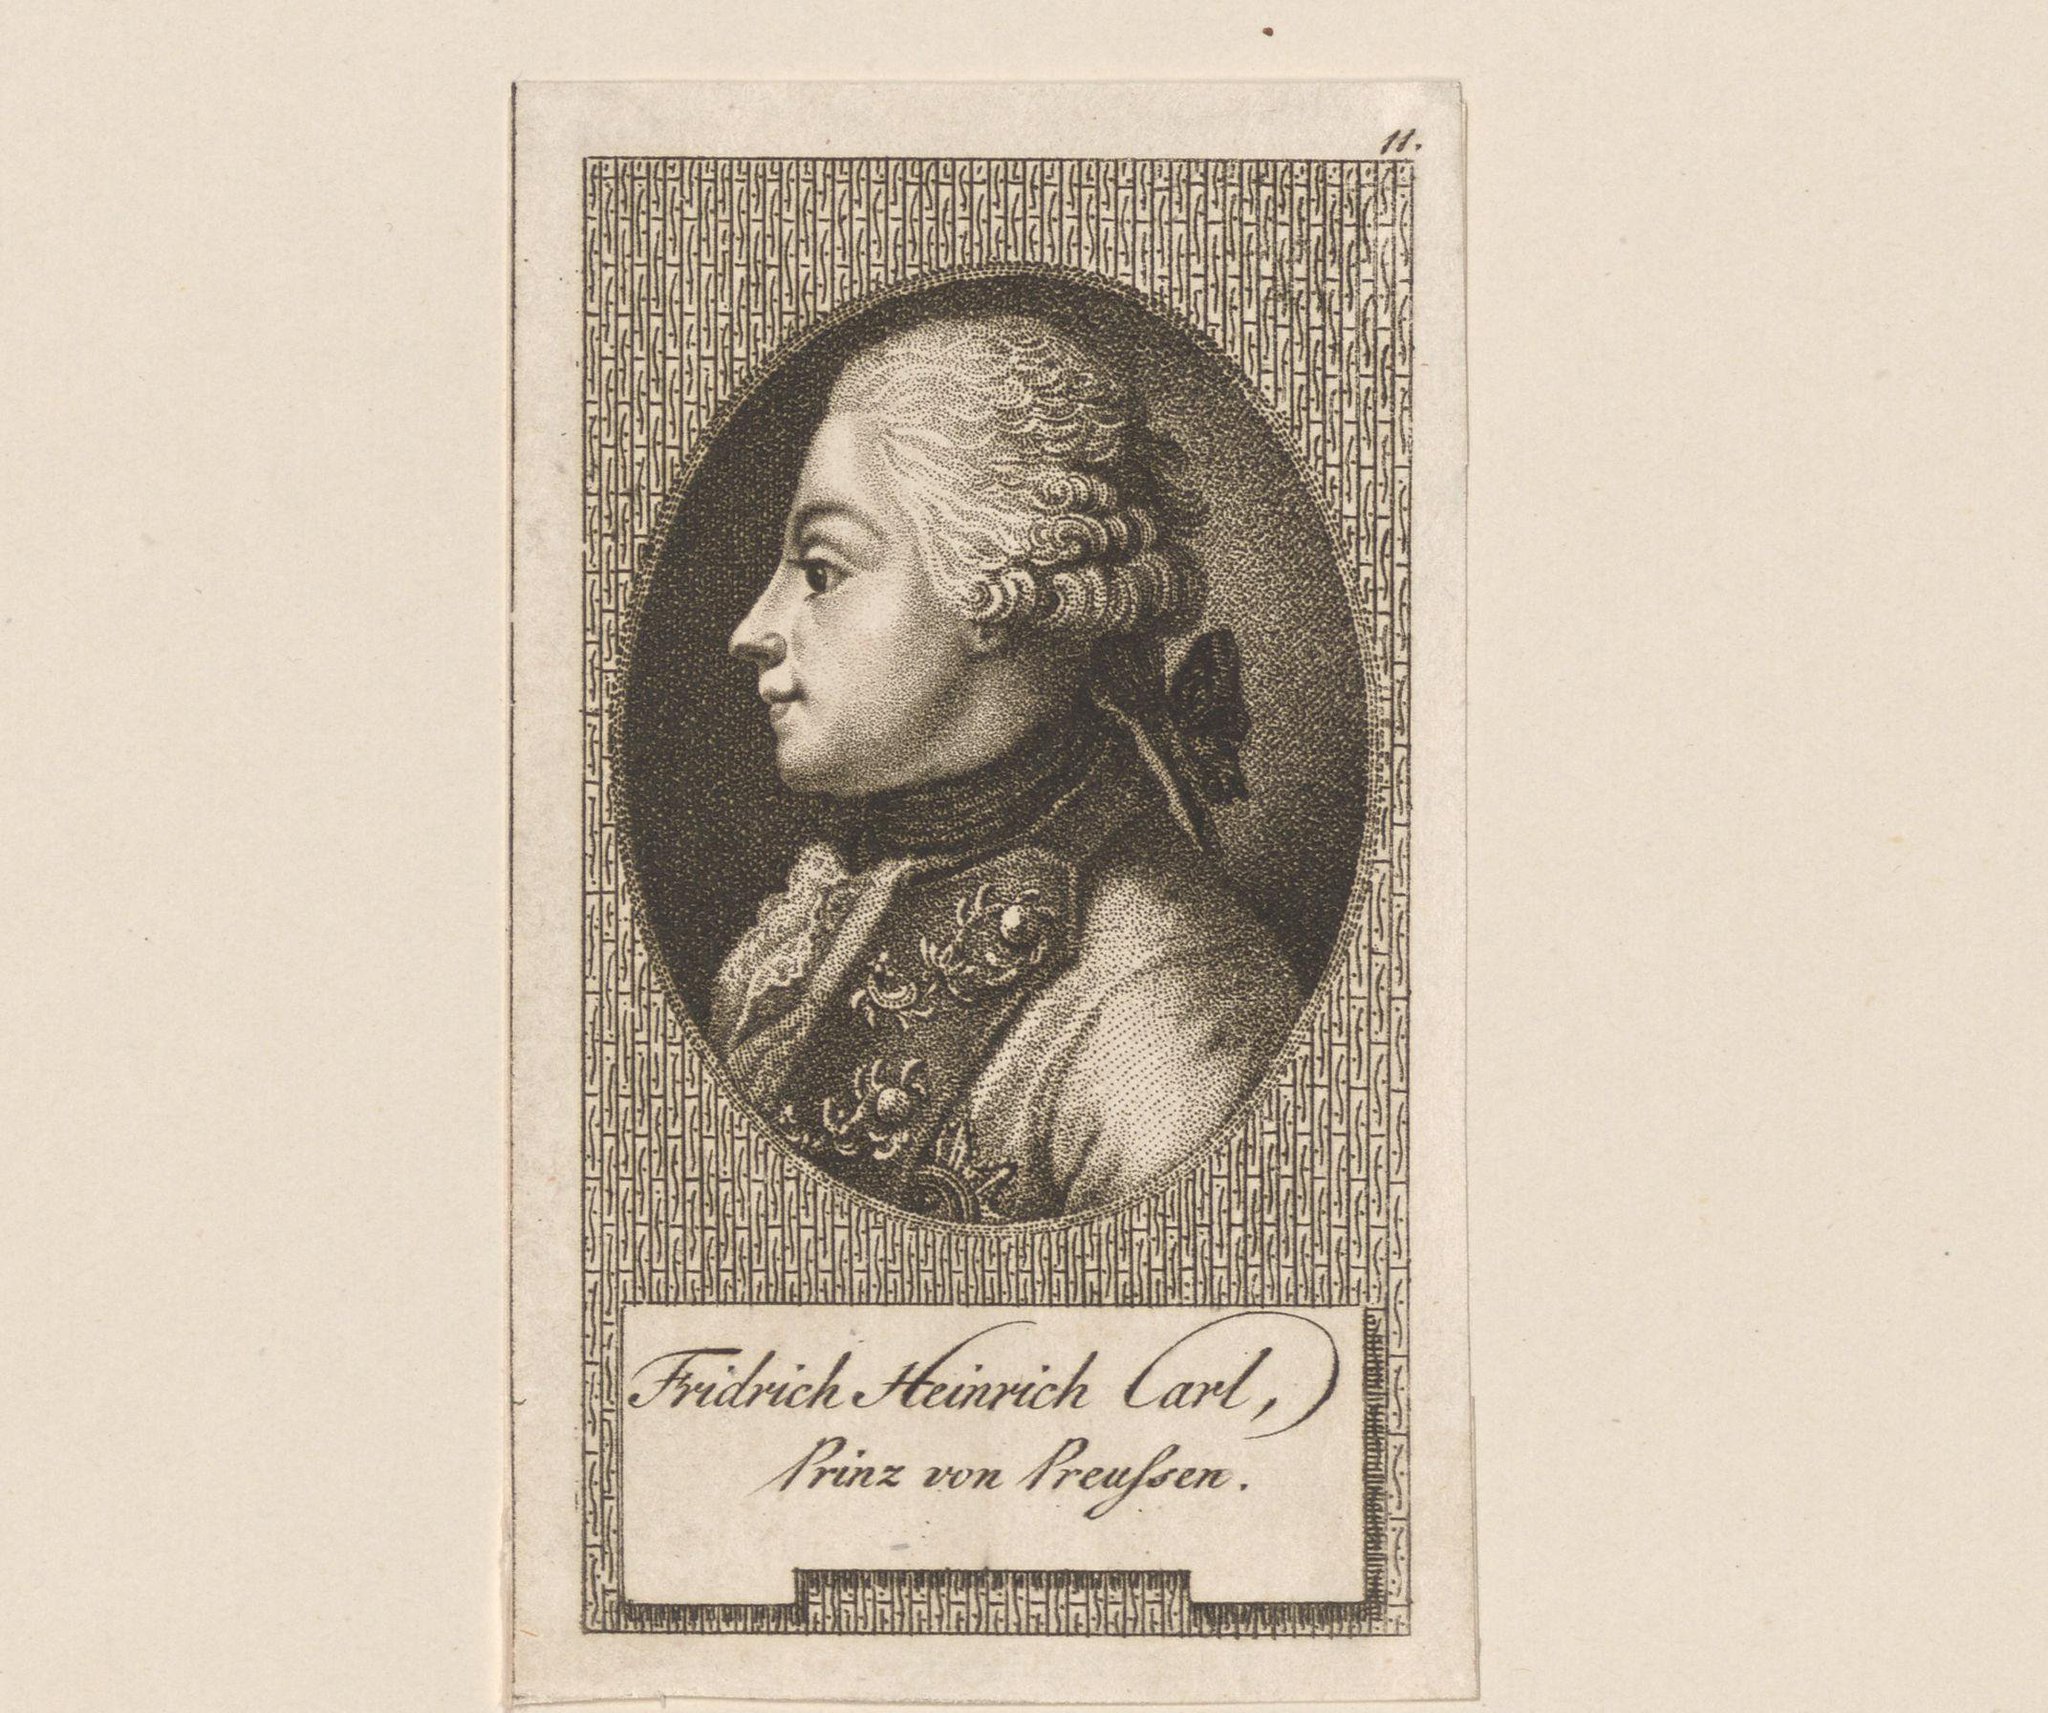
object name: print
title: Portret van Friedrich Heinrich Carl van Pruisen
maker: Anonymous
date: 1760-1799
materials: paper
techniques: etching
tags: berlin, prince, historical persons